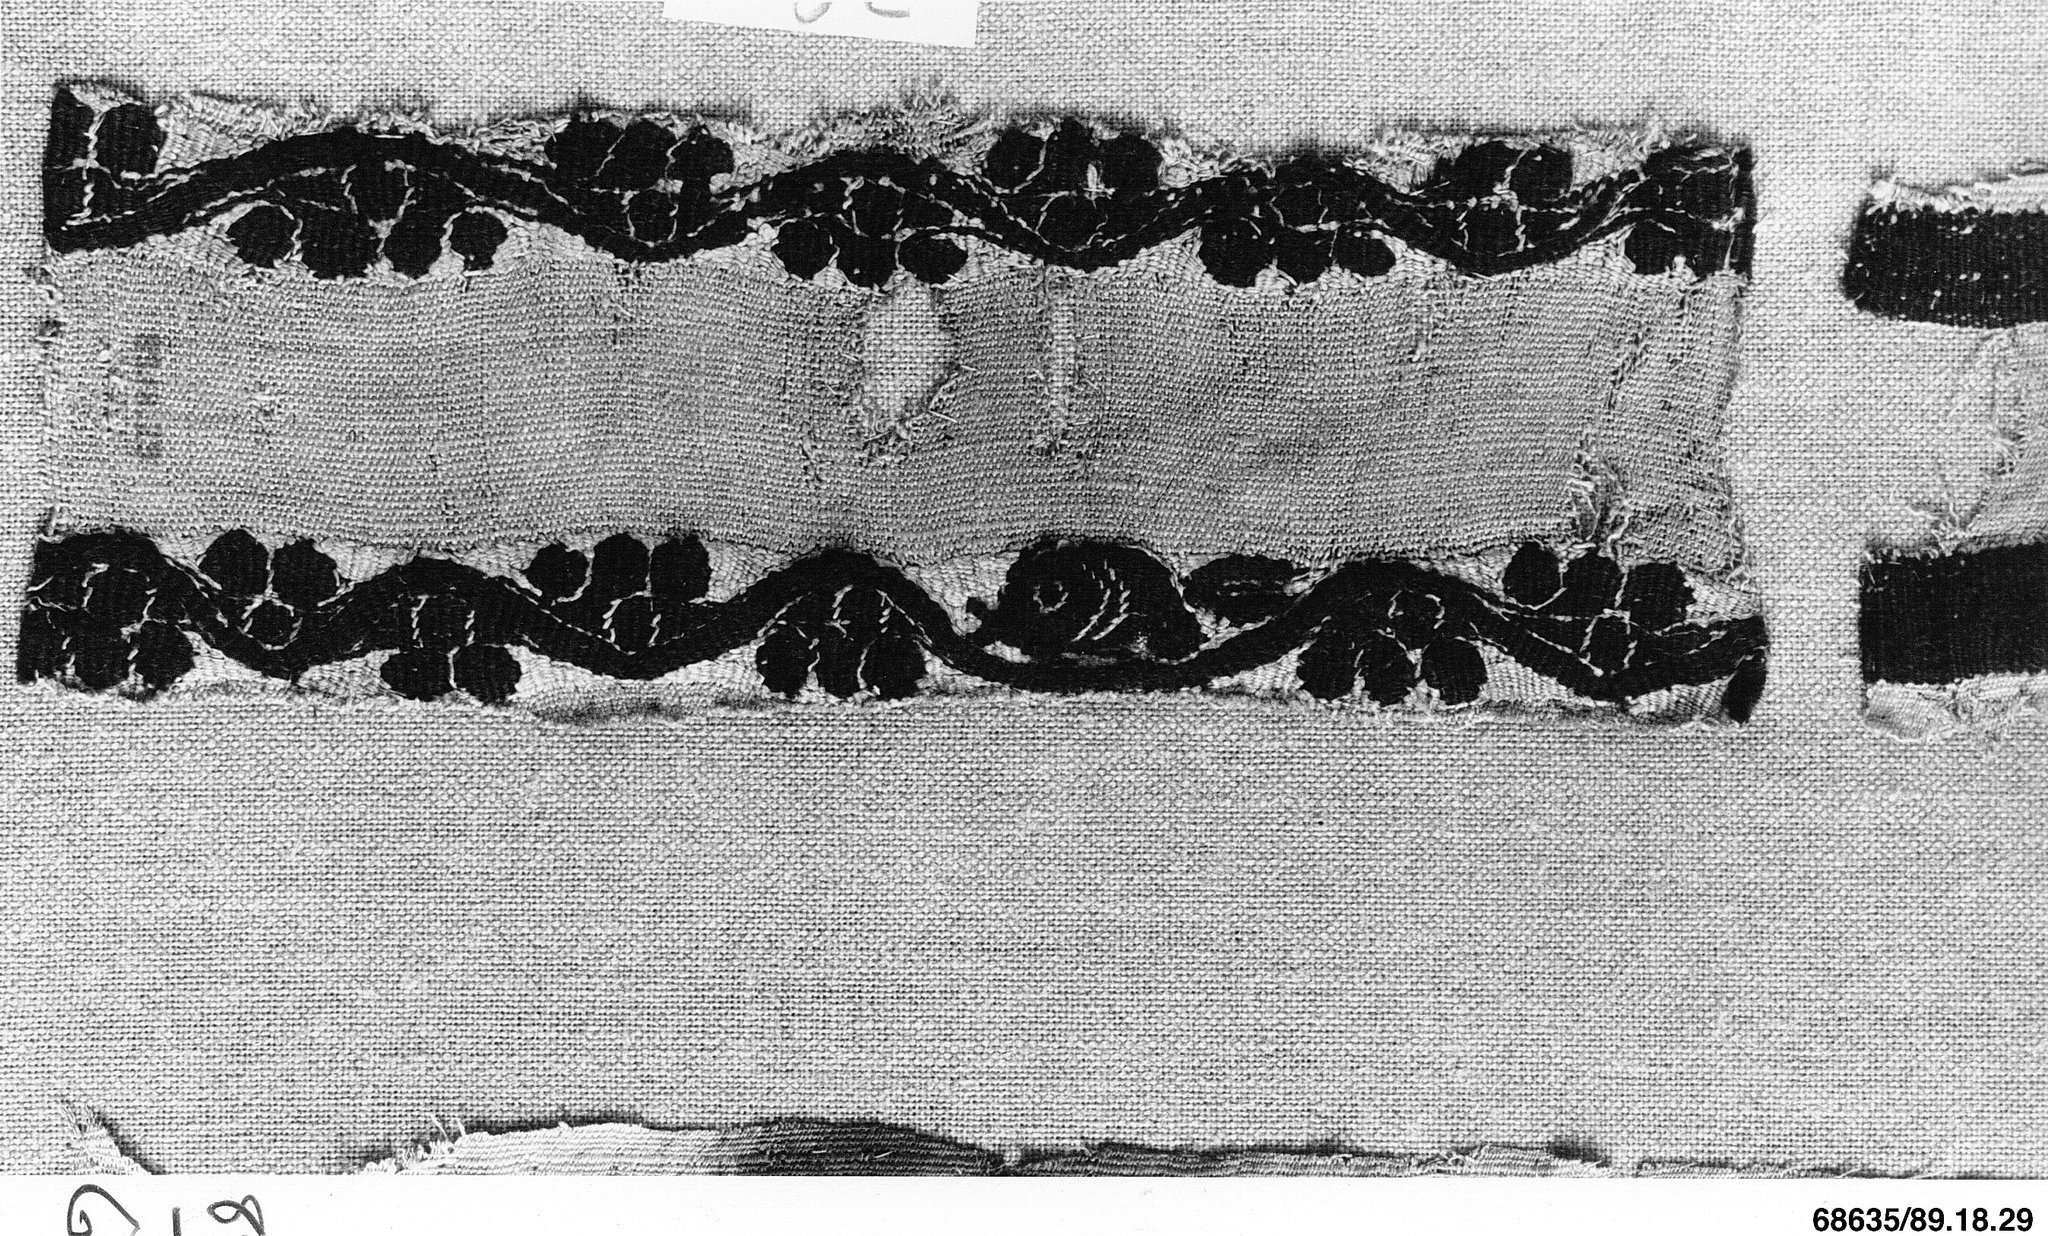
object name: textile fragment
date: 301-500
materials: linen, wool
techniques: weave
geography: egypt